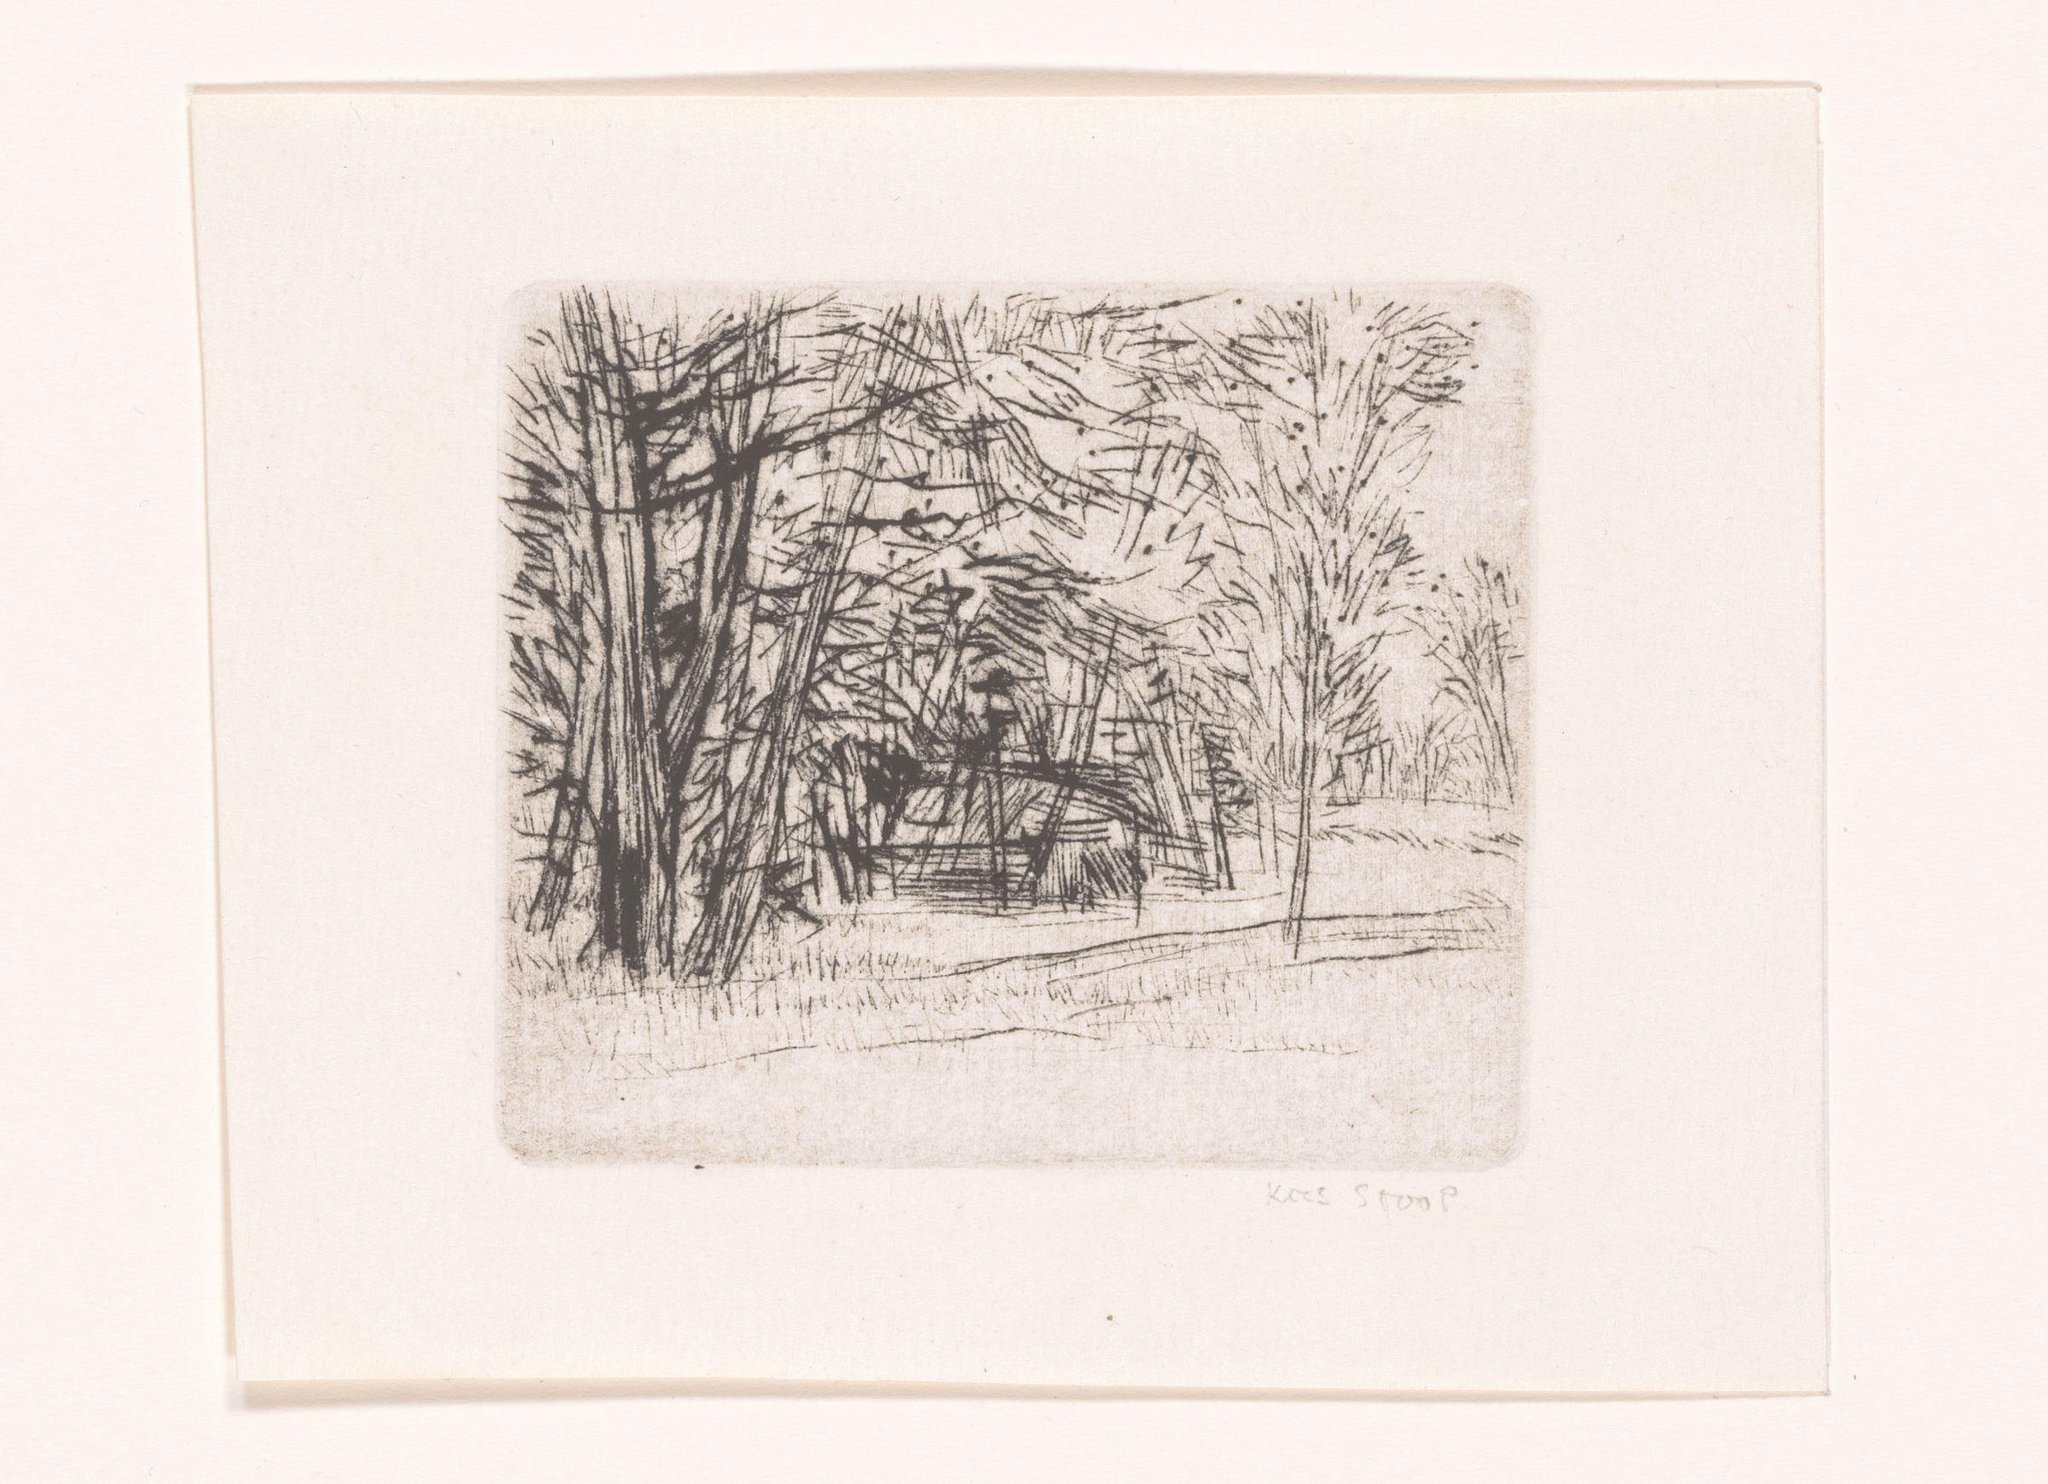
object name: print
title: Bos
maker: kees stoop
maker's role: draughtsman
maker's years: 1929-2019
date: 1944-1990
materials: paper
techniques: drypoint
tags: forest, wood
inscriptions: signature: ‘KEES STOOP’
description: Bos met links op de voorgrond de meeste begroeiing.